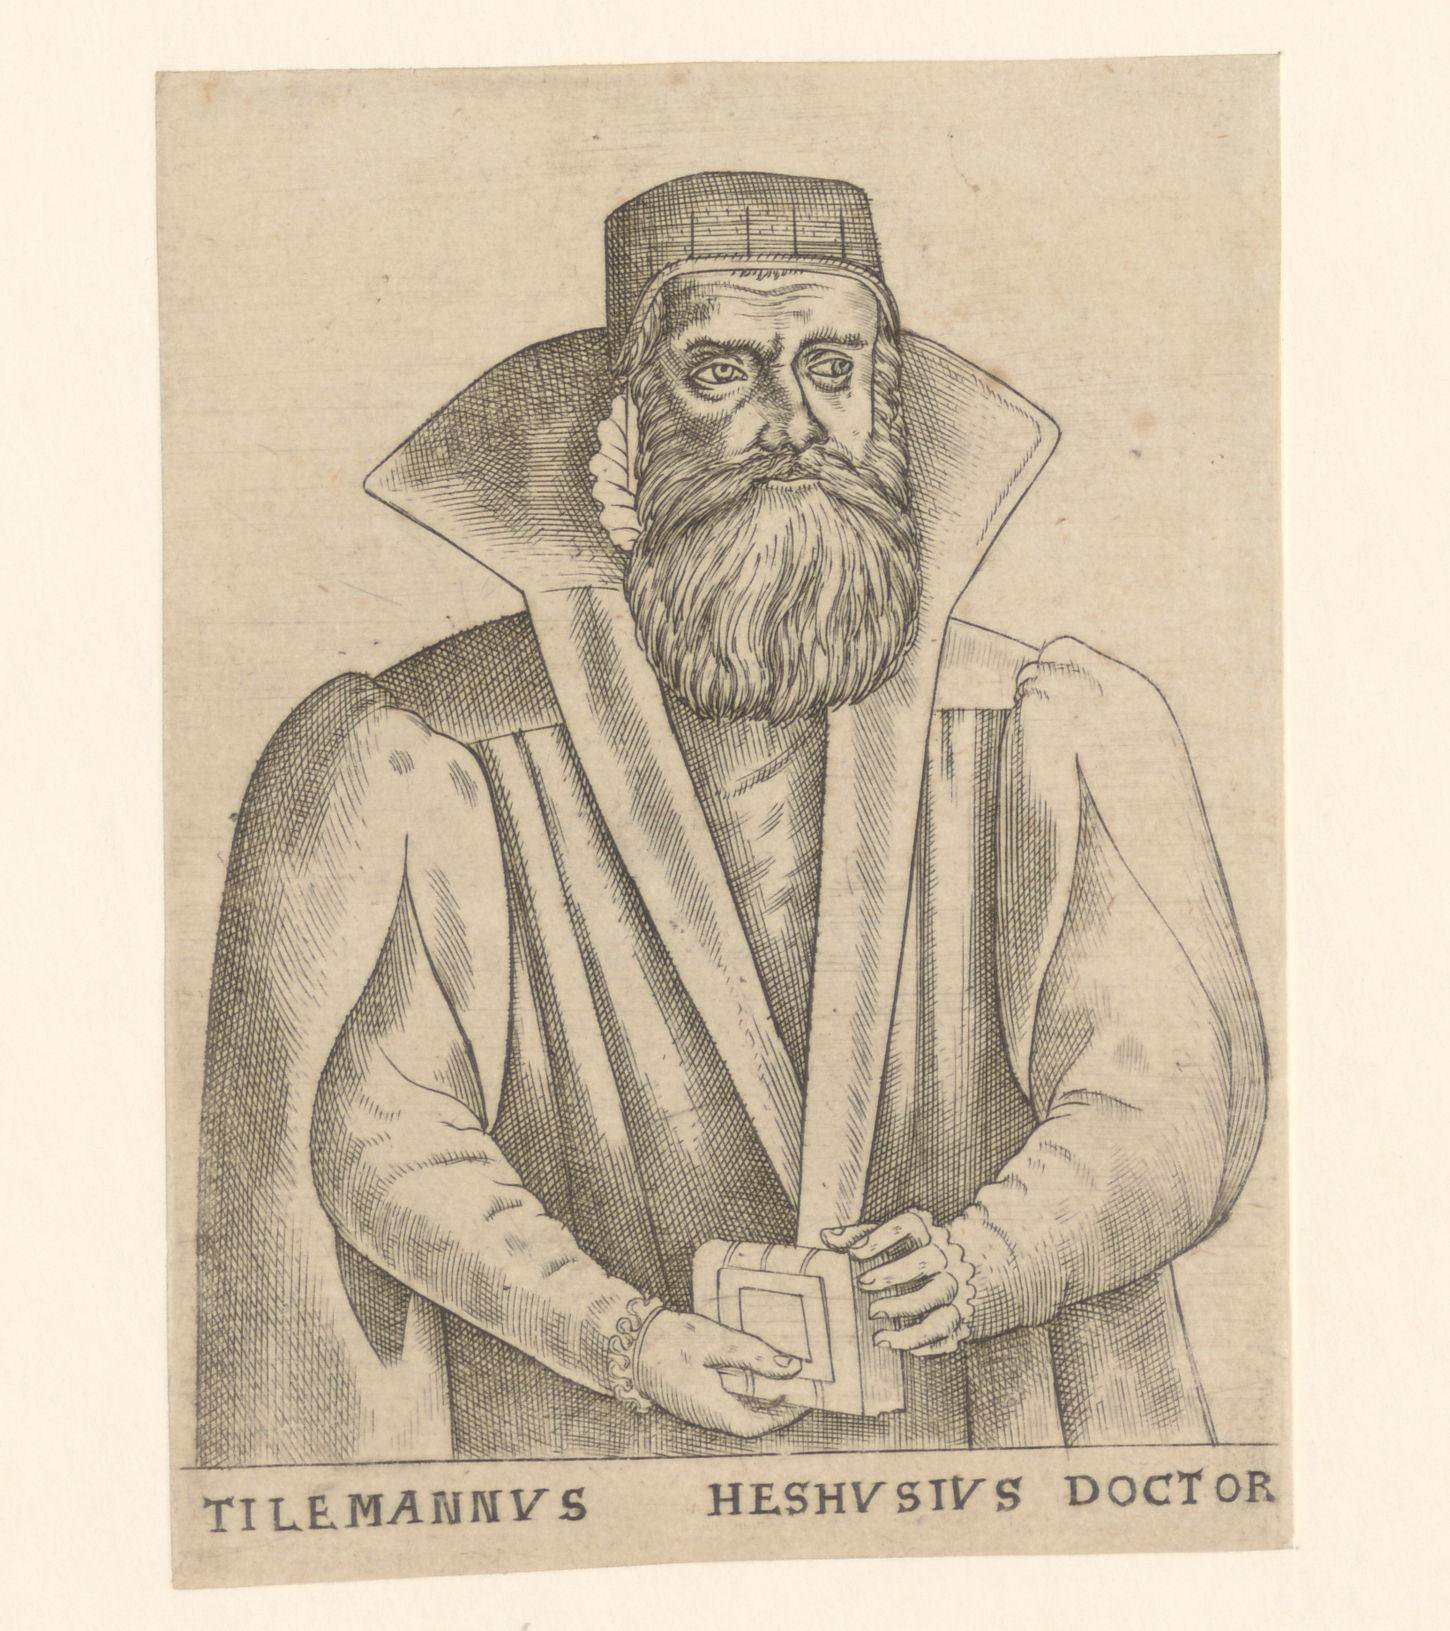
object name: print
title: Portret van Tileman Heshusen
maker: Anonymous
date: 1563-1642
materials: paper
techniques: engraving, etching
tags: theologian, historical persons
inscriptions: collector's mark: Lugt 2228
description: Deze kopie van een prent door Balthasar Jenichen hoort bij een serie portretten van sturende personen tijdens de reformatie, gebruikt in: Agricola, Johann. Bildnüs und Abcontrafactur etzlicher Vornemer Gelerten Menner, durch welche Gott aus sonderbaren gnaden, die rechte reine Warheit des heiligen Evangelii, zu diesen unsern und beschrieben (...). Dresden: Gimmel Bergen, 1588.